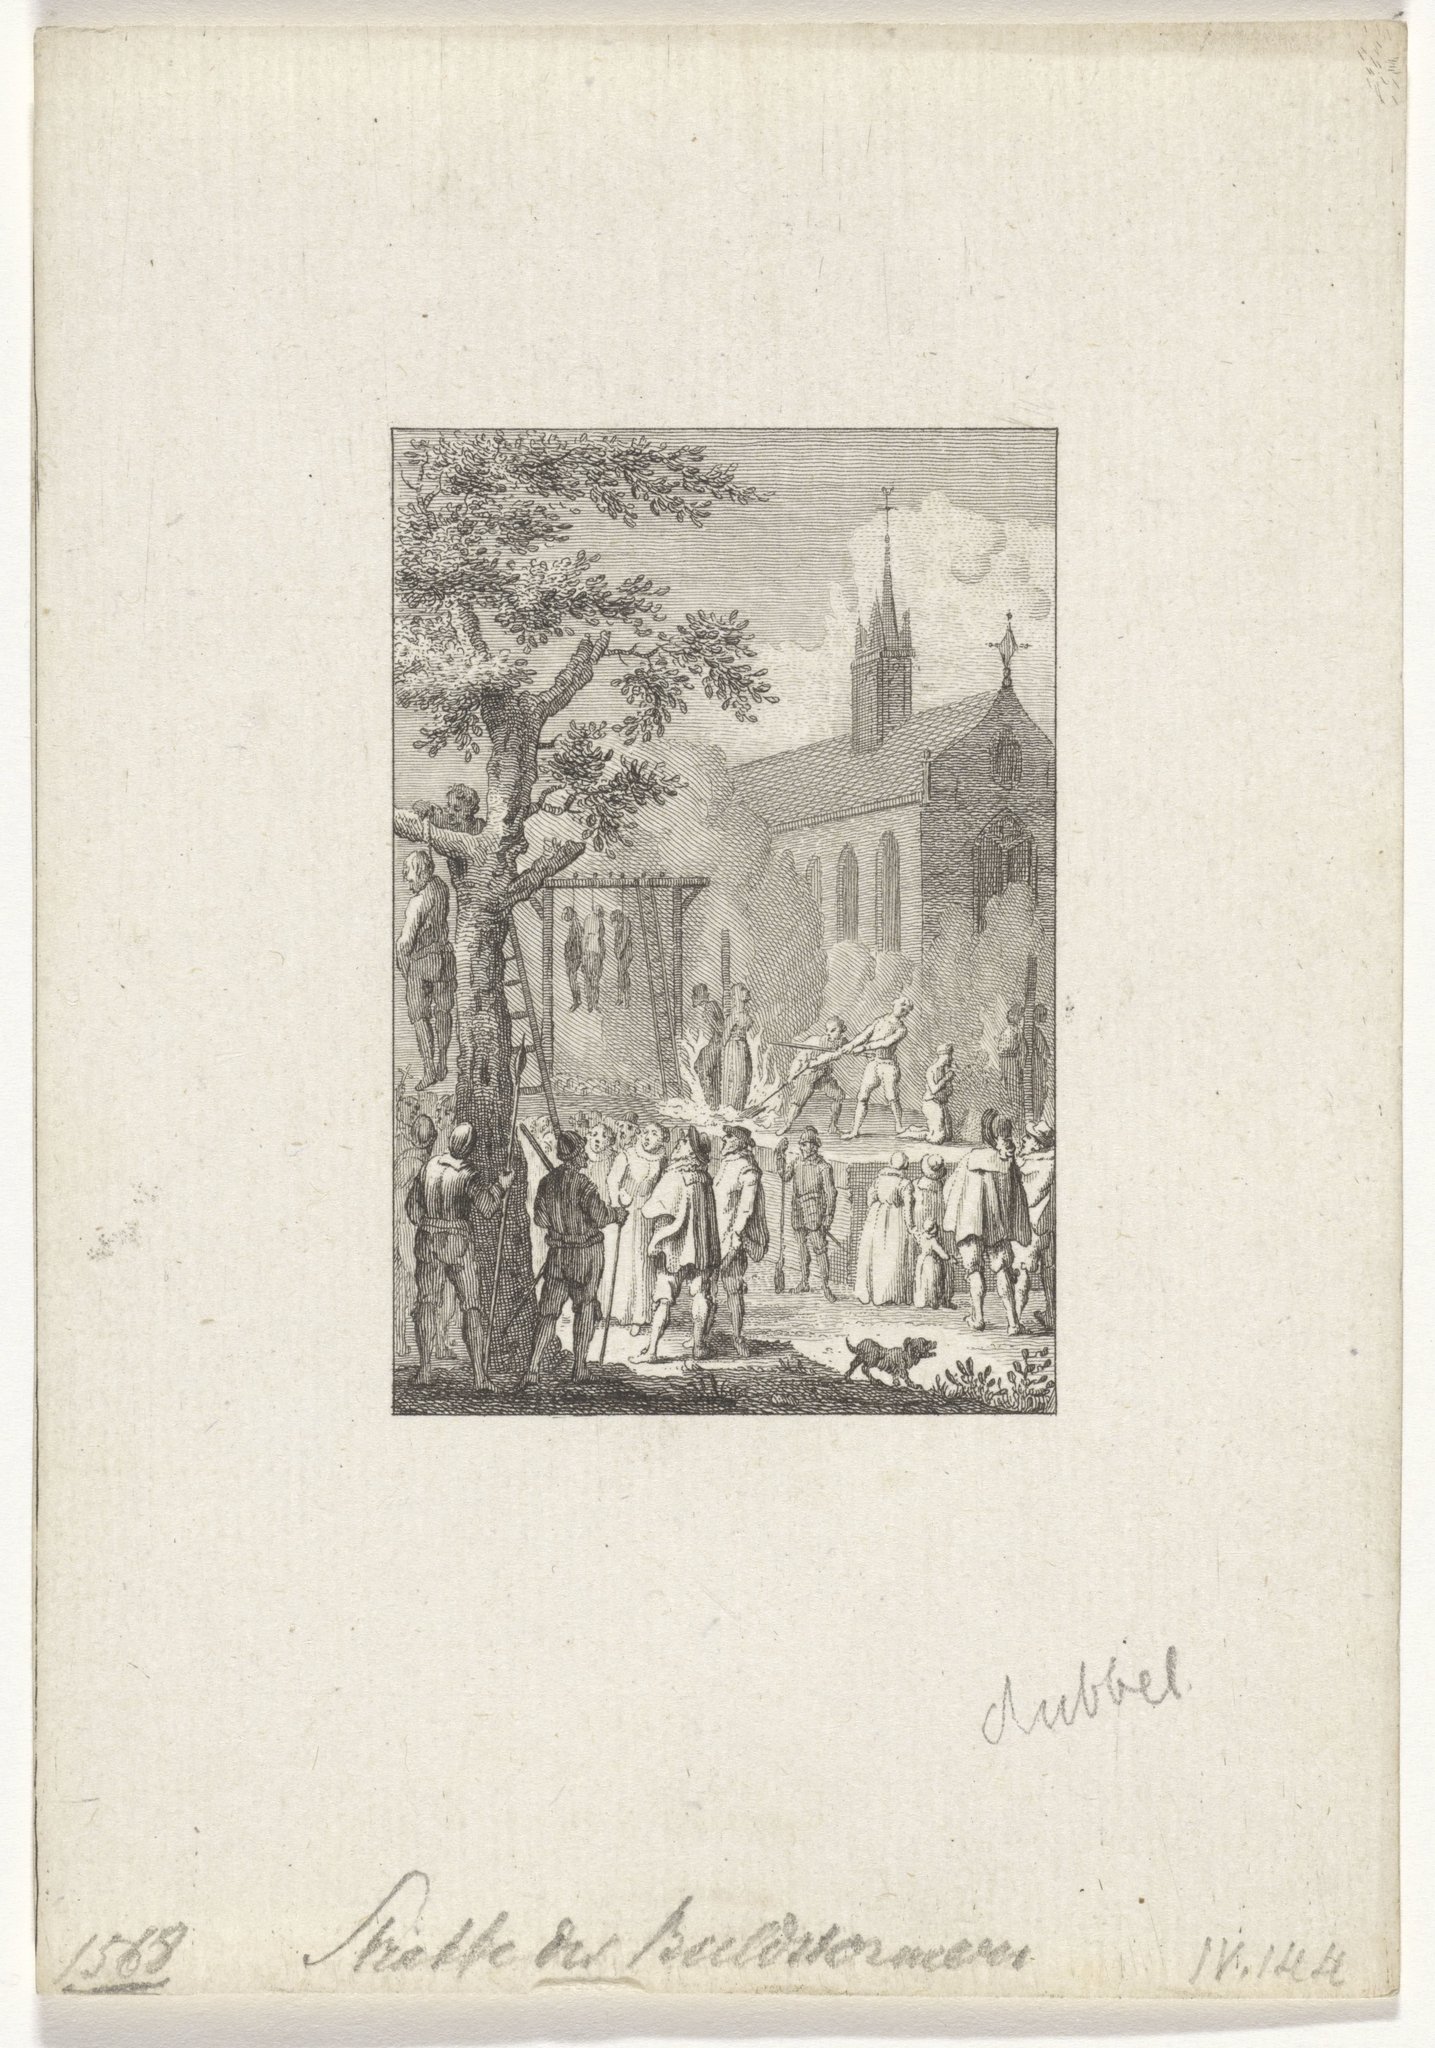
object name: print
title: Terechtstellingen van beeldenstormers, 1567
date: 1783-1795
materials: paper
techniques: etching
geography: amsterdam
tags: execution of heretic, e.g. by burning at the stake, 'auto-da-fé', on the scaffold or place of execution, violent death, being killed; being mishandled and maltreated; seeking death, beeldenstorm (1566)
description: Illustratie voor: J. Fokke. Geschiedenissen der Vereenigde Nederlanden voor de vaderlandsche jeugd. Amsterdam: Johannes Allart, 1783-1795, 25 delen. deel IV pl. IV.